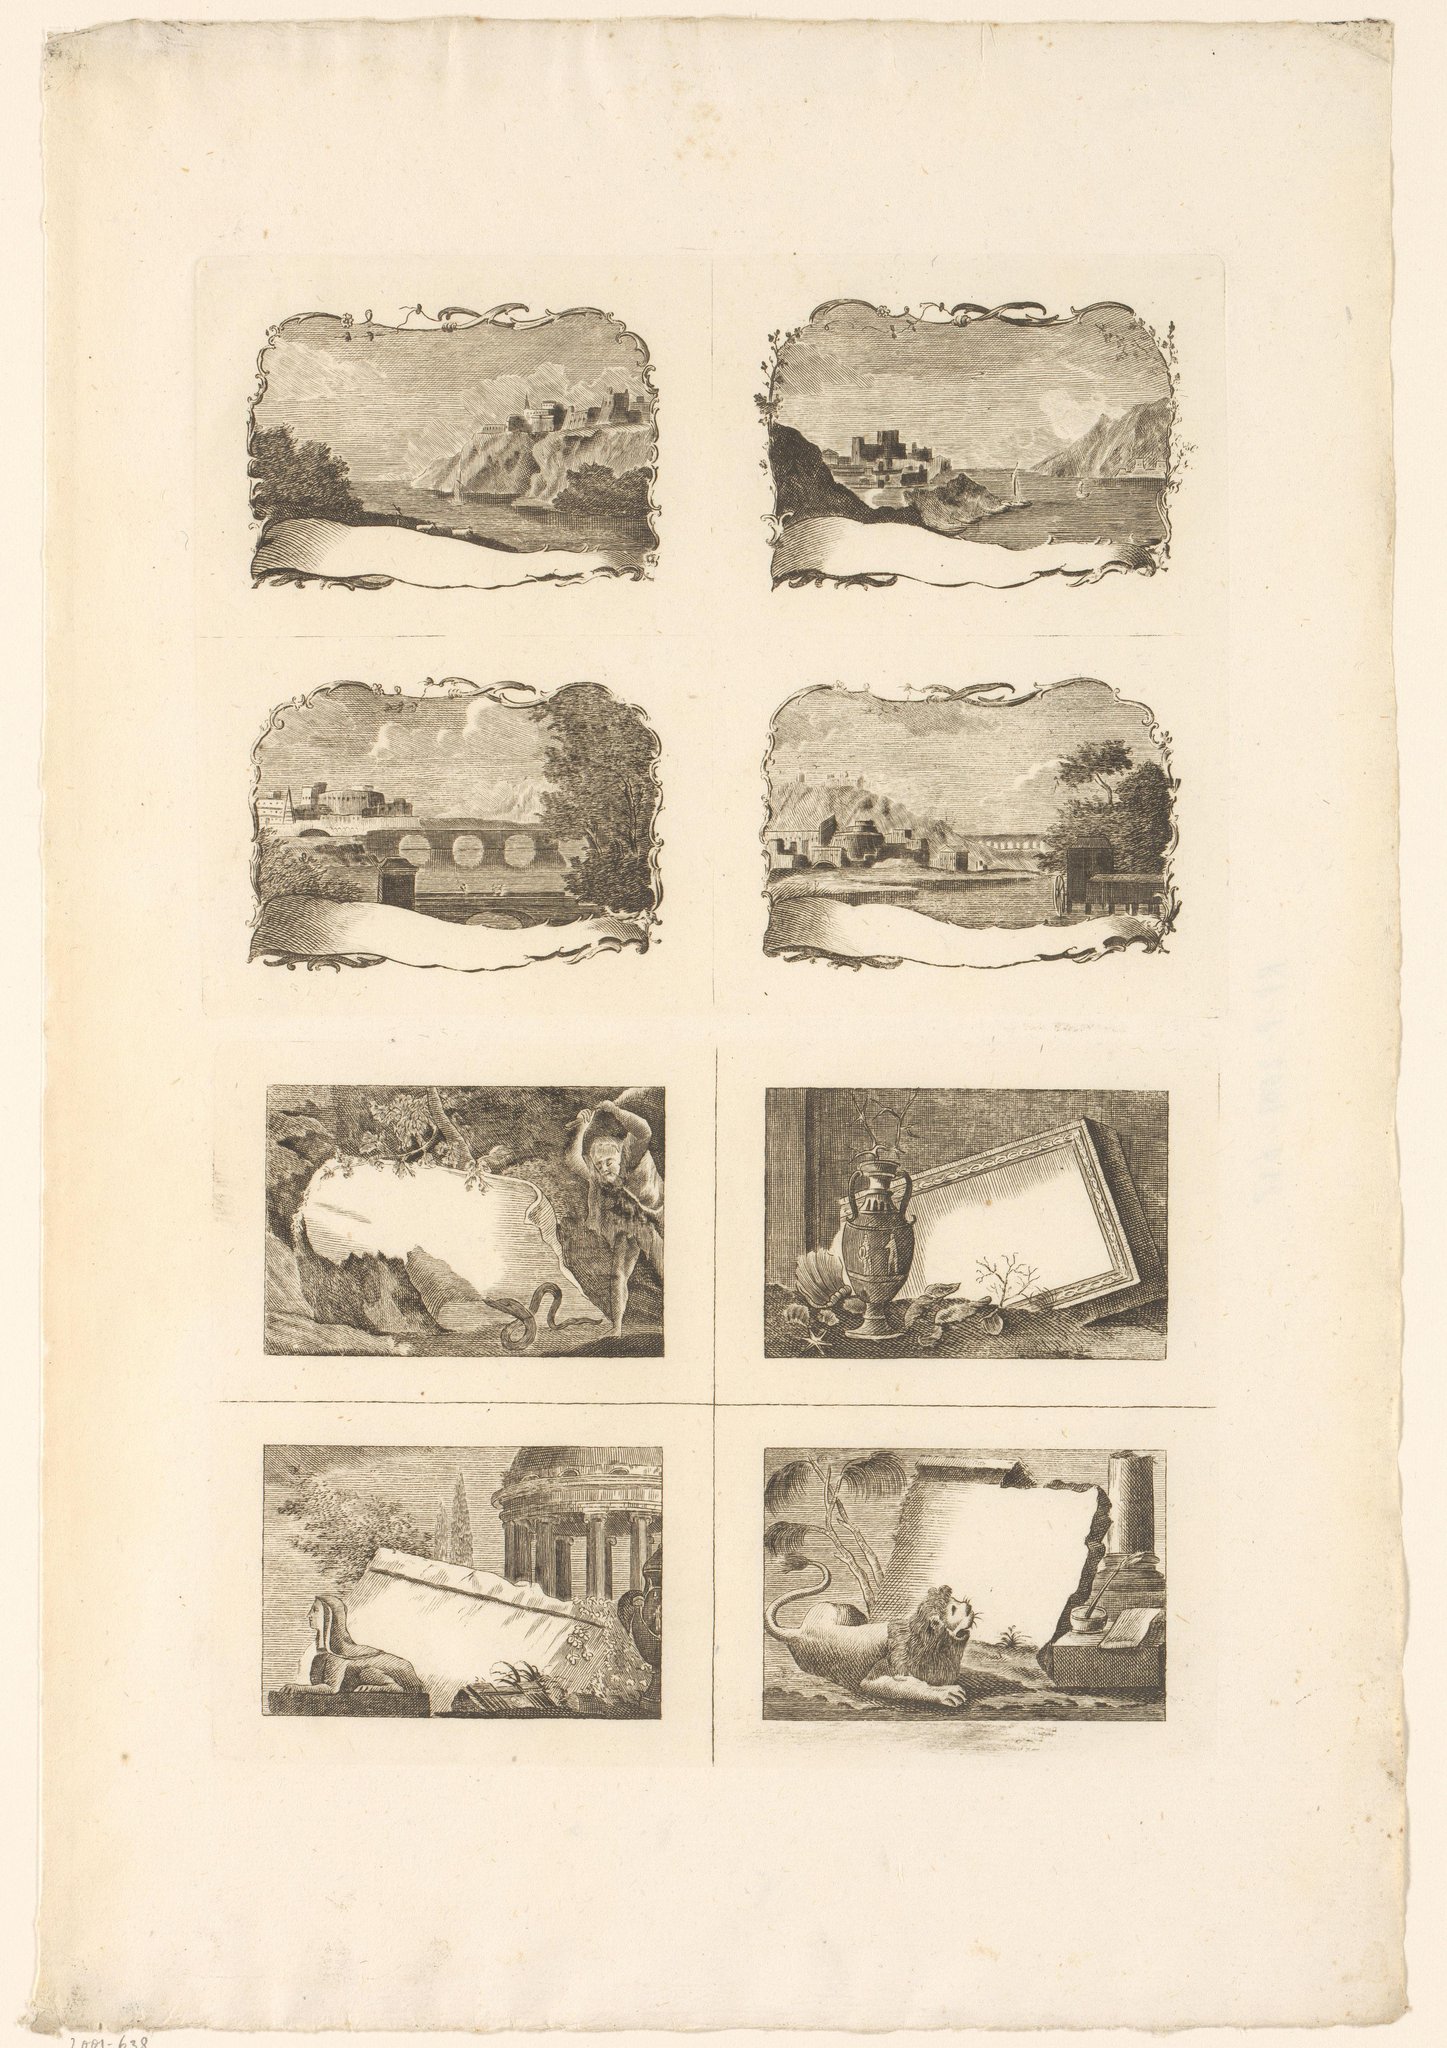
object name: print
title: Acht ontwerpen voor visitekaartjes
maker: Anonymous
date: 1700-1799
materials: paper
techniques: engraving, etching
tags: sphinx (lion/woman); 'sfinge' (ripa), landscapes in the temperate zone, vase ~ ornament, ornament ~ cartouche, beasts of prey, predatory animals: lion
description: Acht ontwerpen voor visitekaartjes: vier landschappen met een lege banderol voor de naam, en vier taferelen met verwijzingen naar de oudheid met lege cartouches voor de naam.